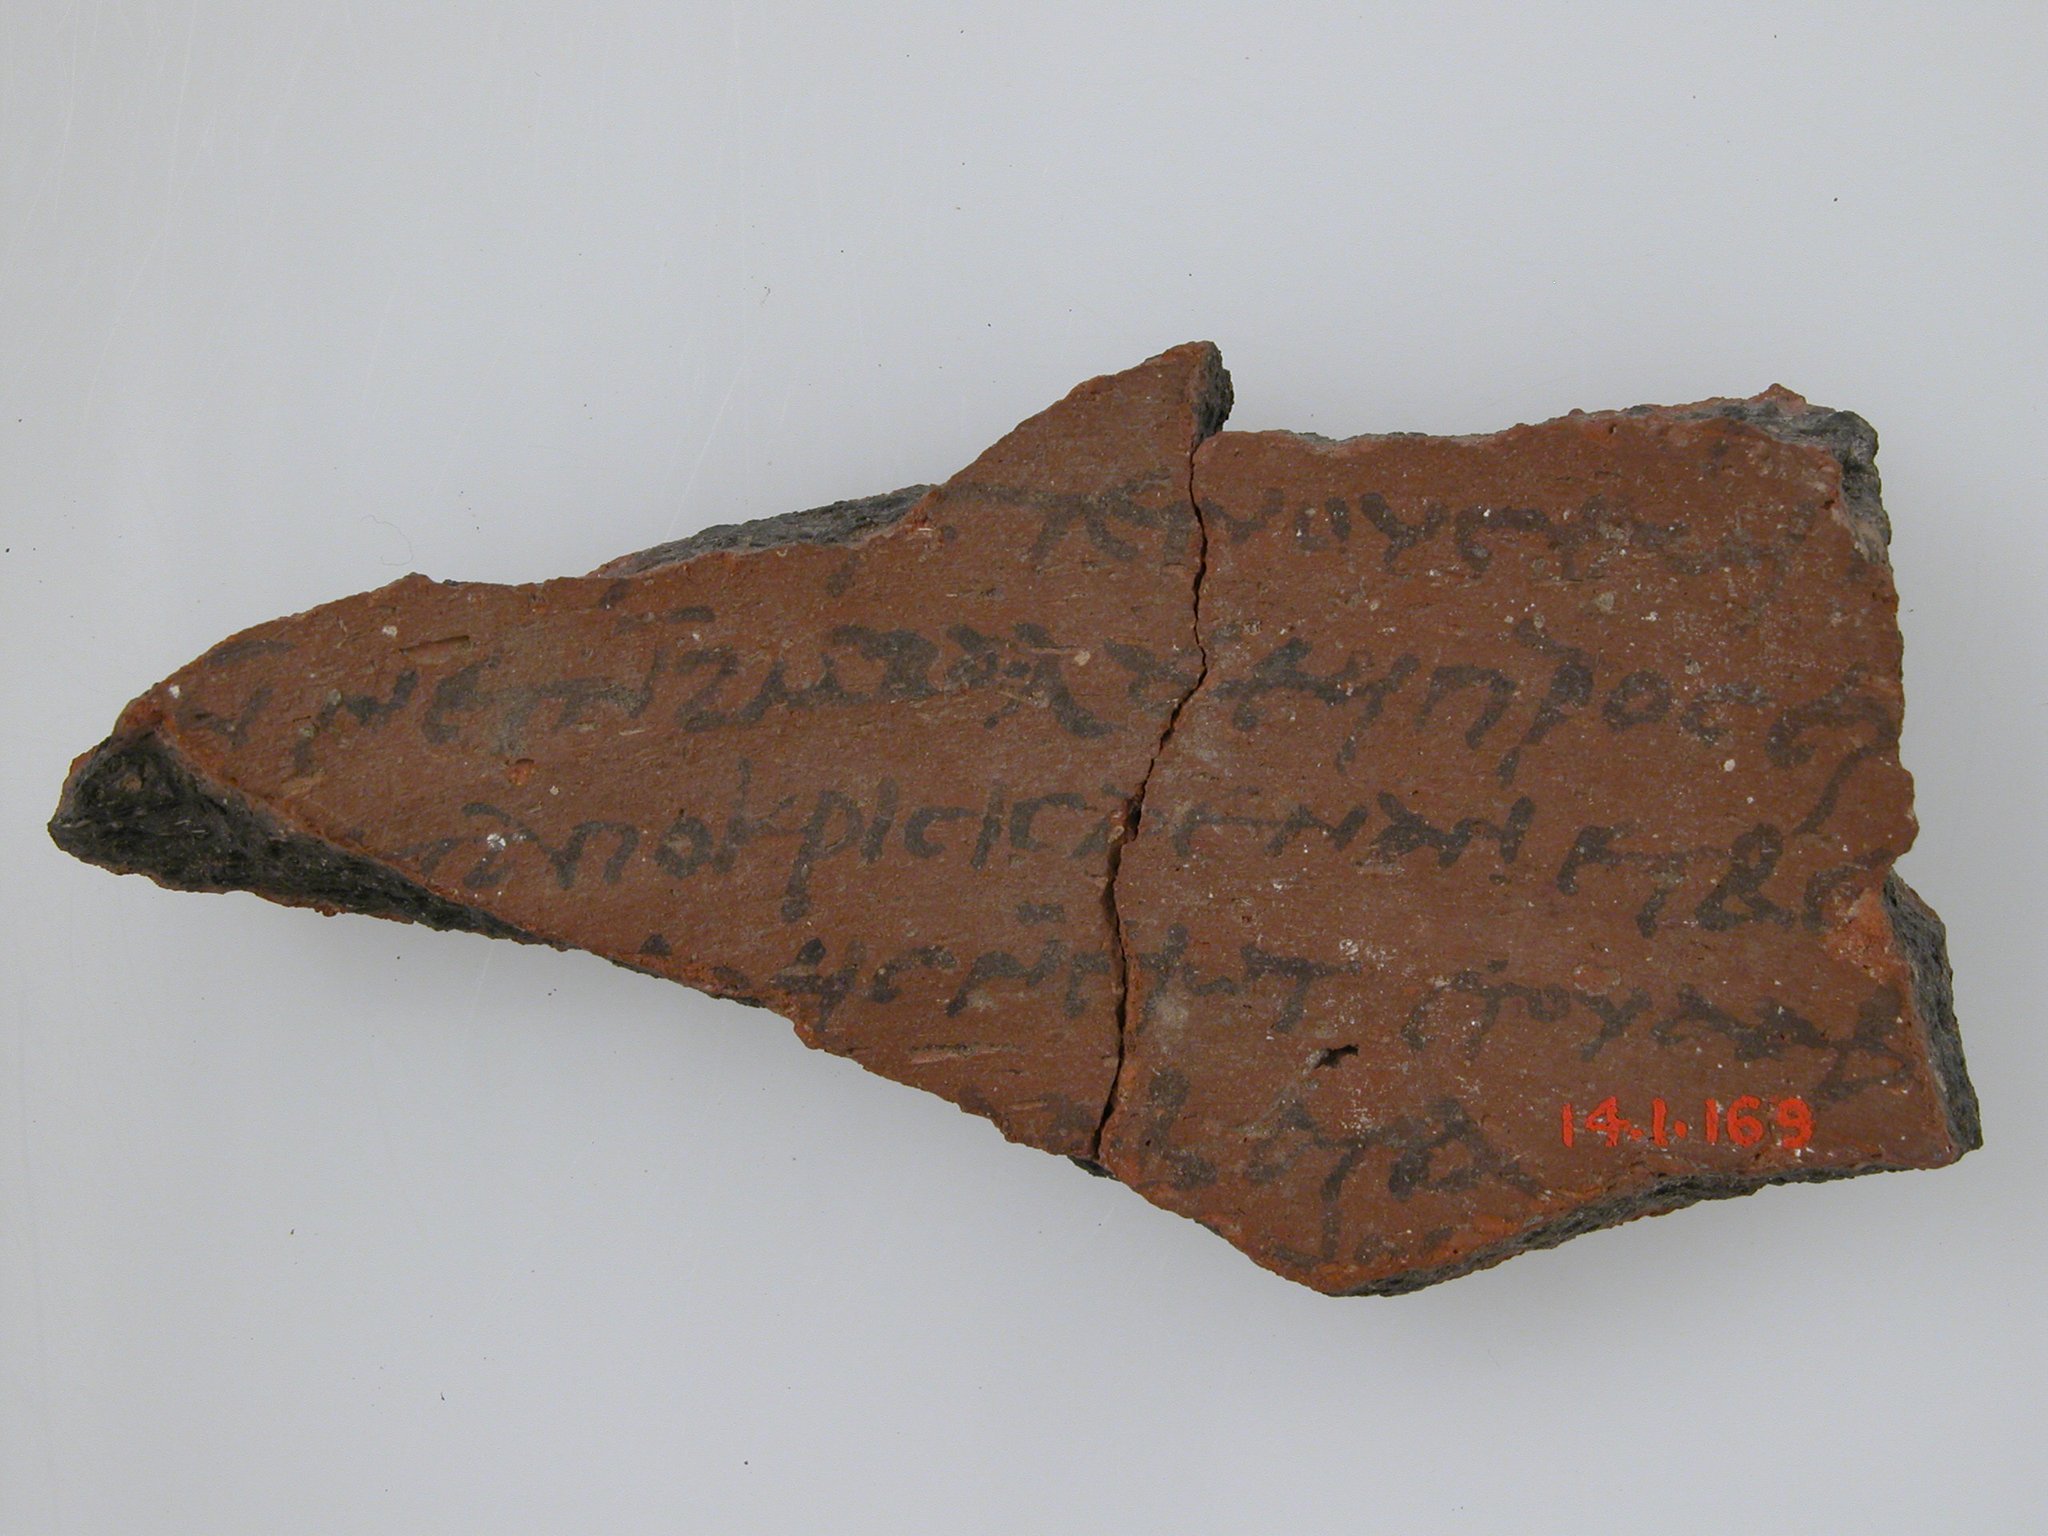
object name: ostrakon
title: Ostrakon with a Letter to Epiphanius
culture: coptic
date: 580-640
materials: ink, pottery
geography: egypt